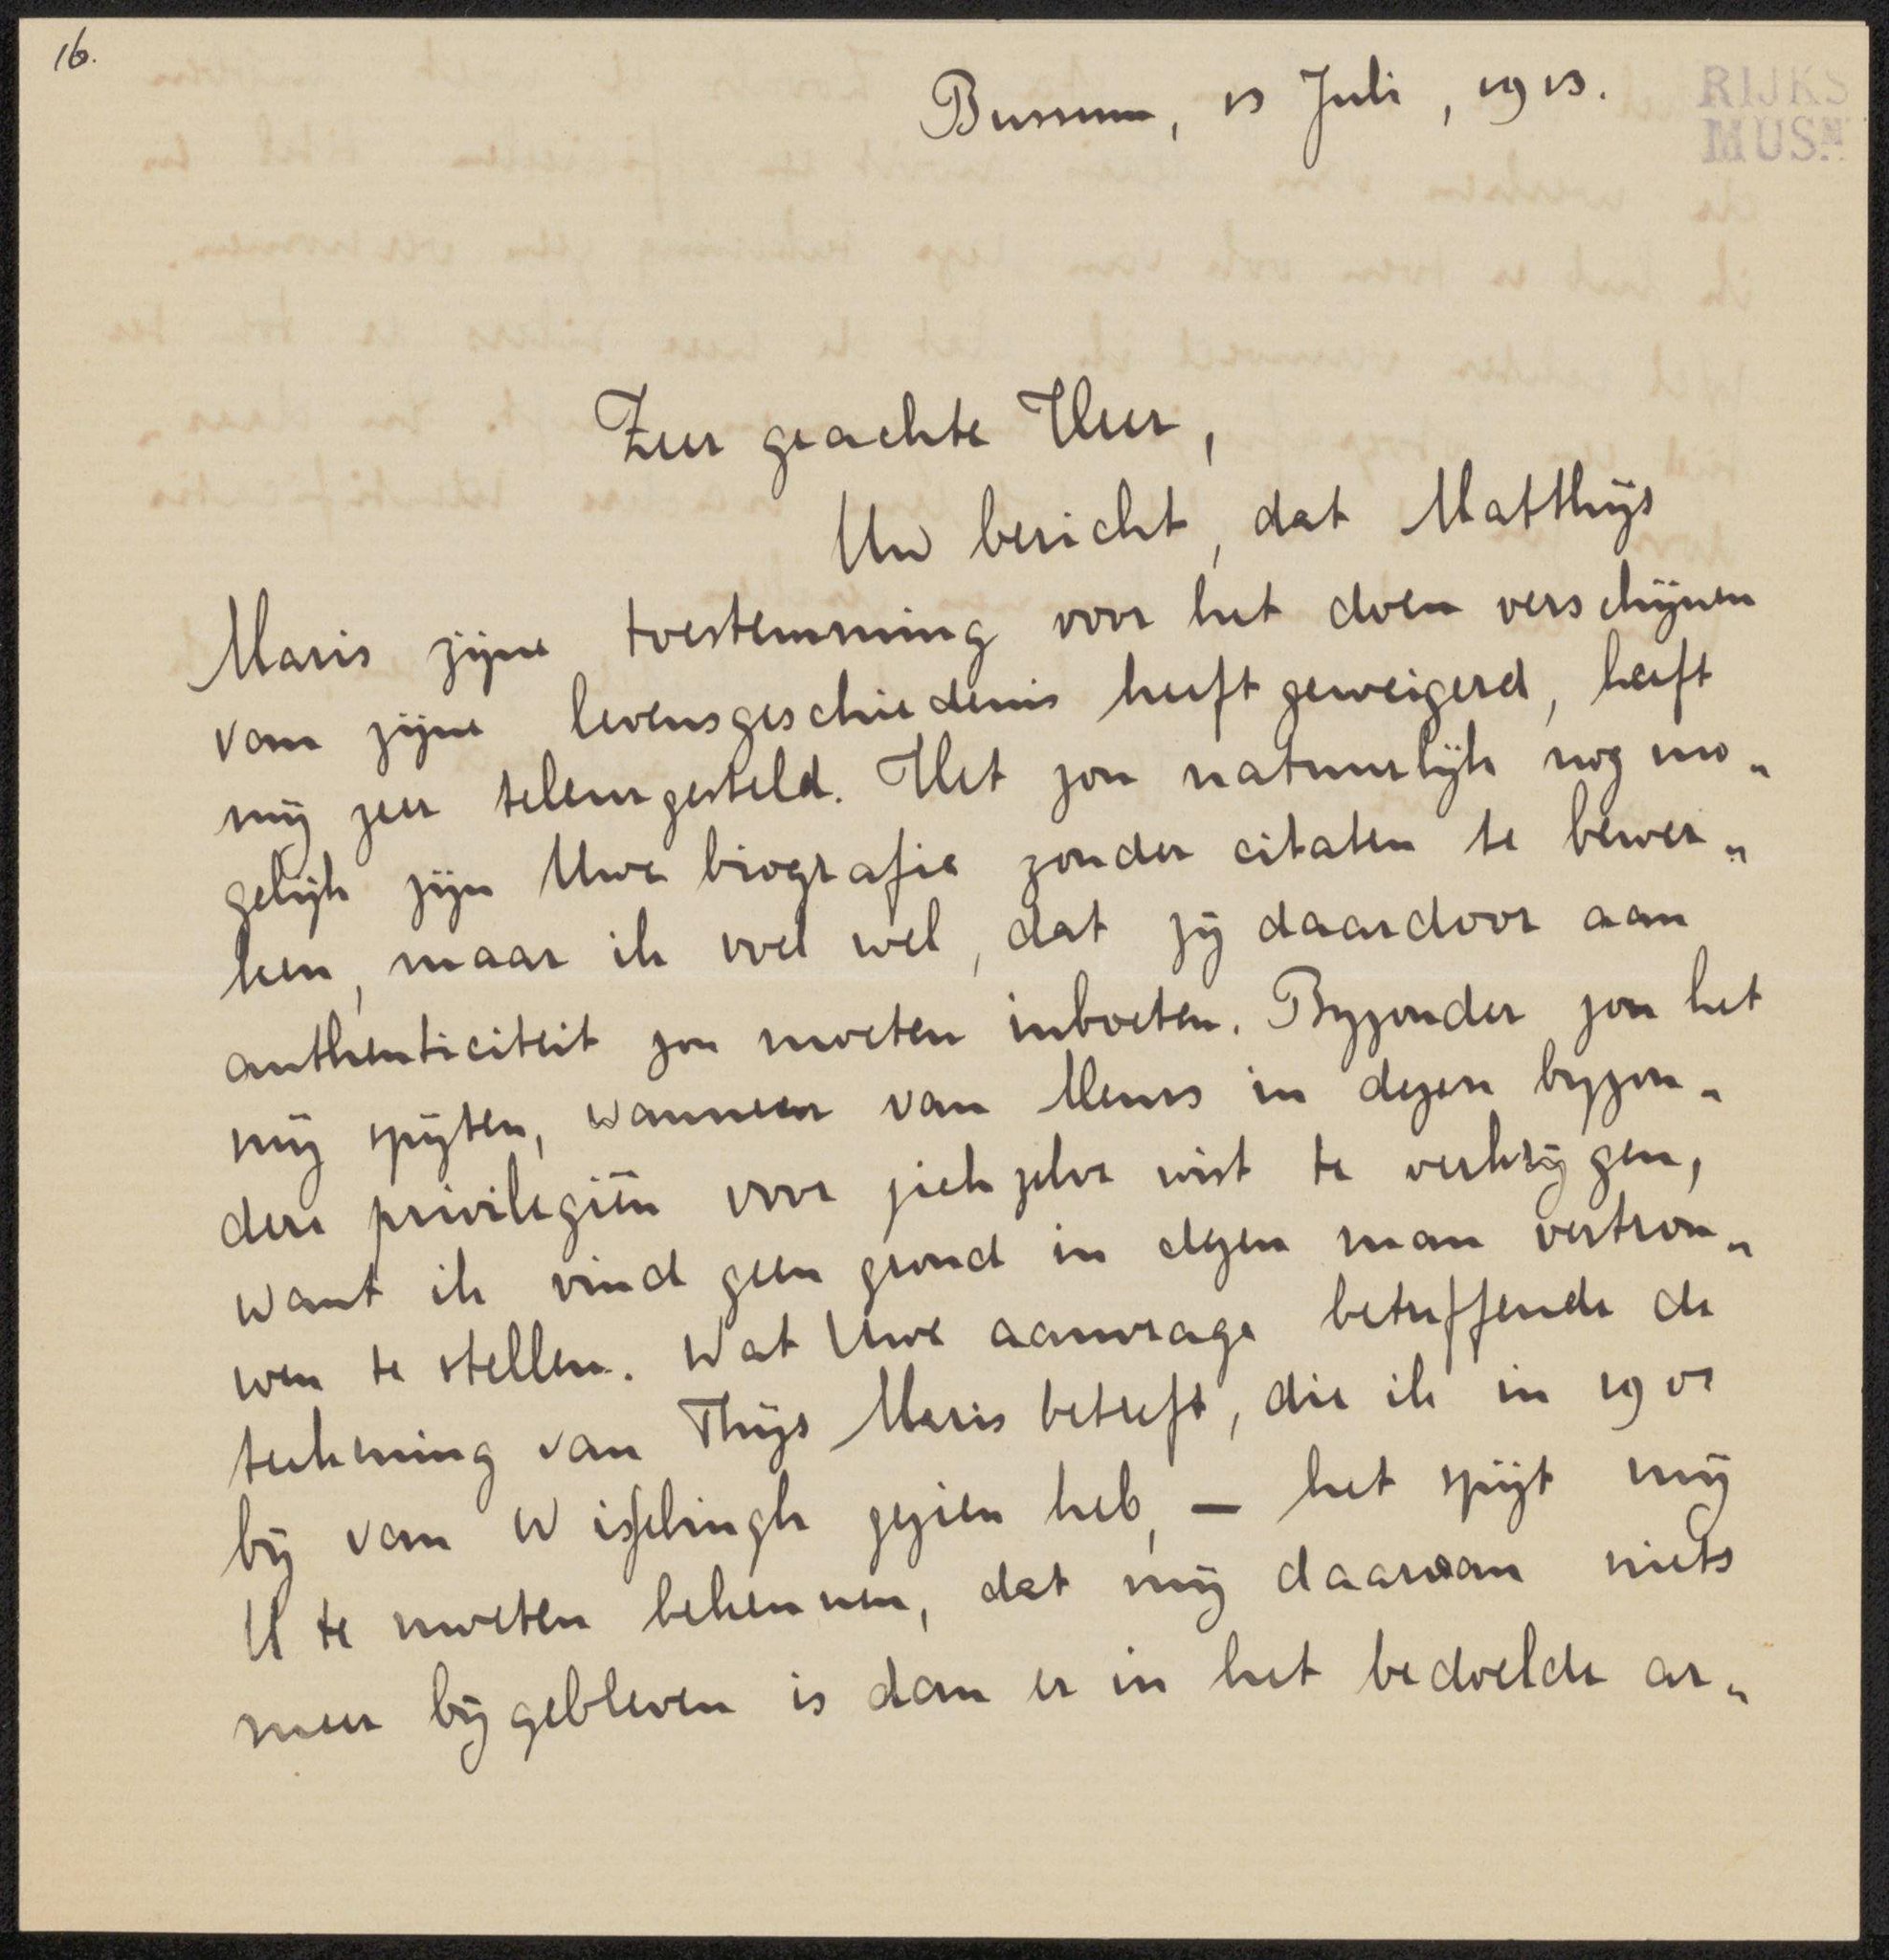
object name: letter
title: Brief aan Pieter Haverkorn van Rijsewijk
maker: jan veth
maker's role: designer, draughtsman, painter, print maker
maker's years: 1864-1925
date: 1913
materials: ink, paper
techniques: pen, writing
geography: bussum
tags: the hague, matthijs maris, amsterdam, bernard eilers, pieter haverkorn van rijsewijk, drawing, photography, cinematography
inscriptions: collector's mark: Lugt 2166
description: De brief is ondertekend door Jan Veth, de brief is geschreven met een andere hand.